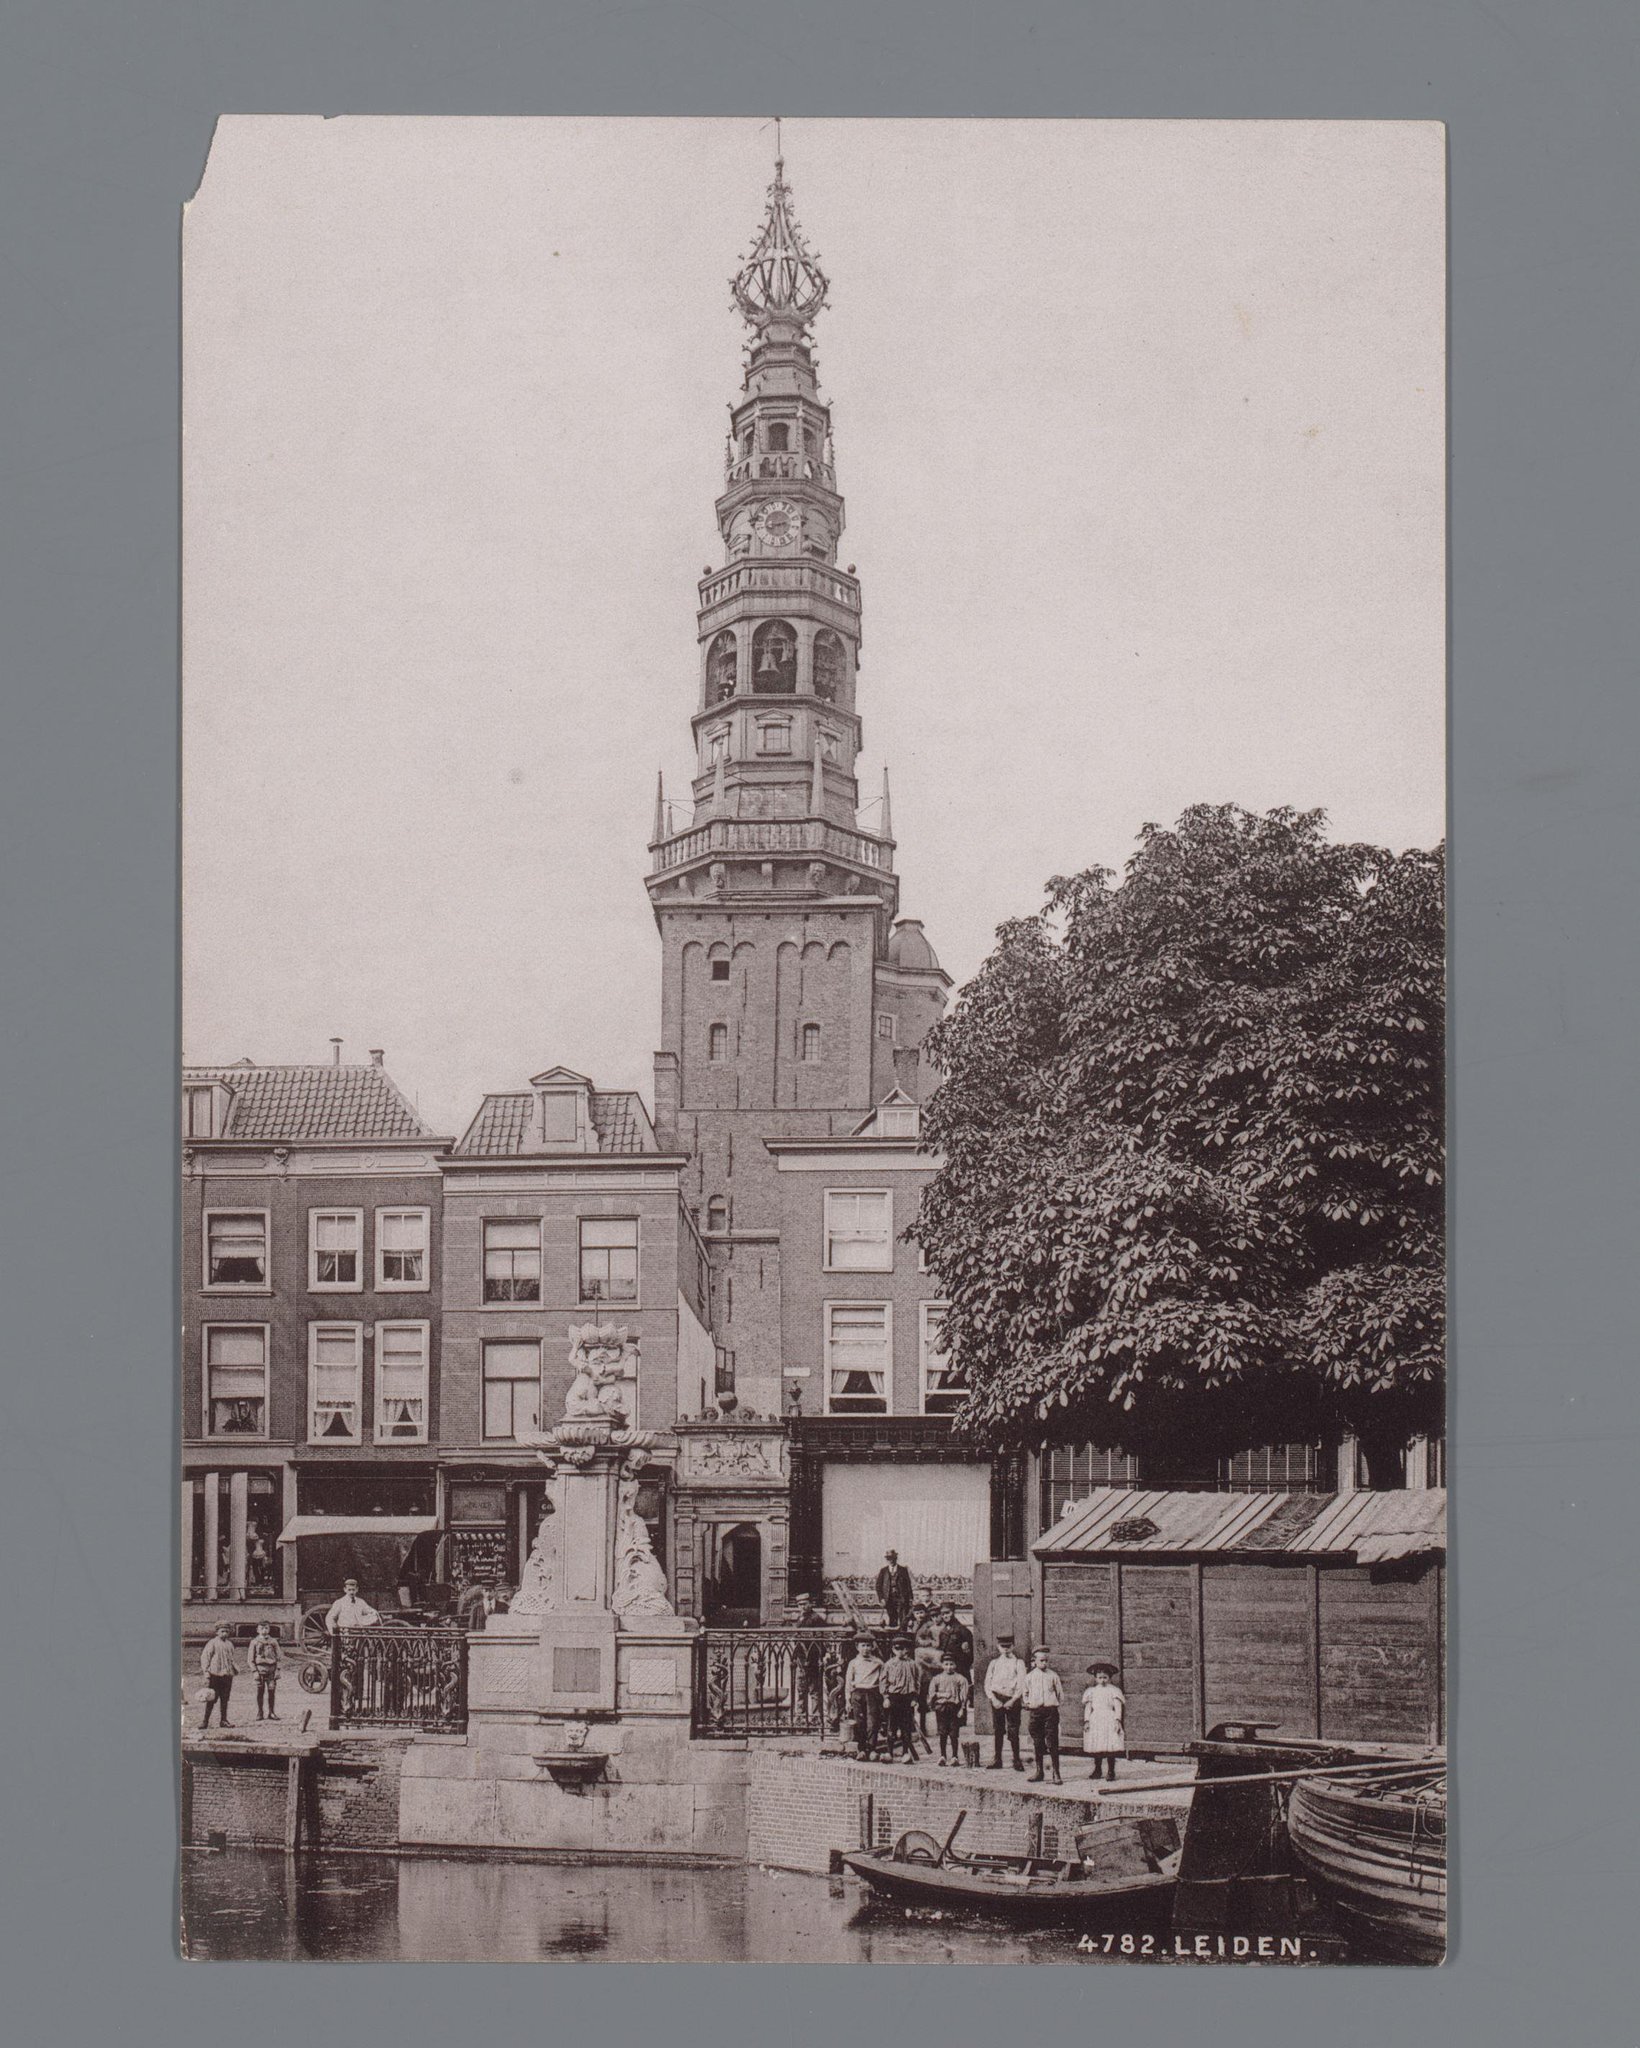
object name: photomechanical print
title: Gezicht op de Vismarkt met de toren van het stadhuis te Leiden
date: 1880-1910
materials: paper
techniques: photograph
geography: dresden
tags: townhall, ornamental fountain, leiden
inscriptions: inscription: ‘4782. Leiden.’